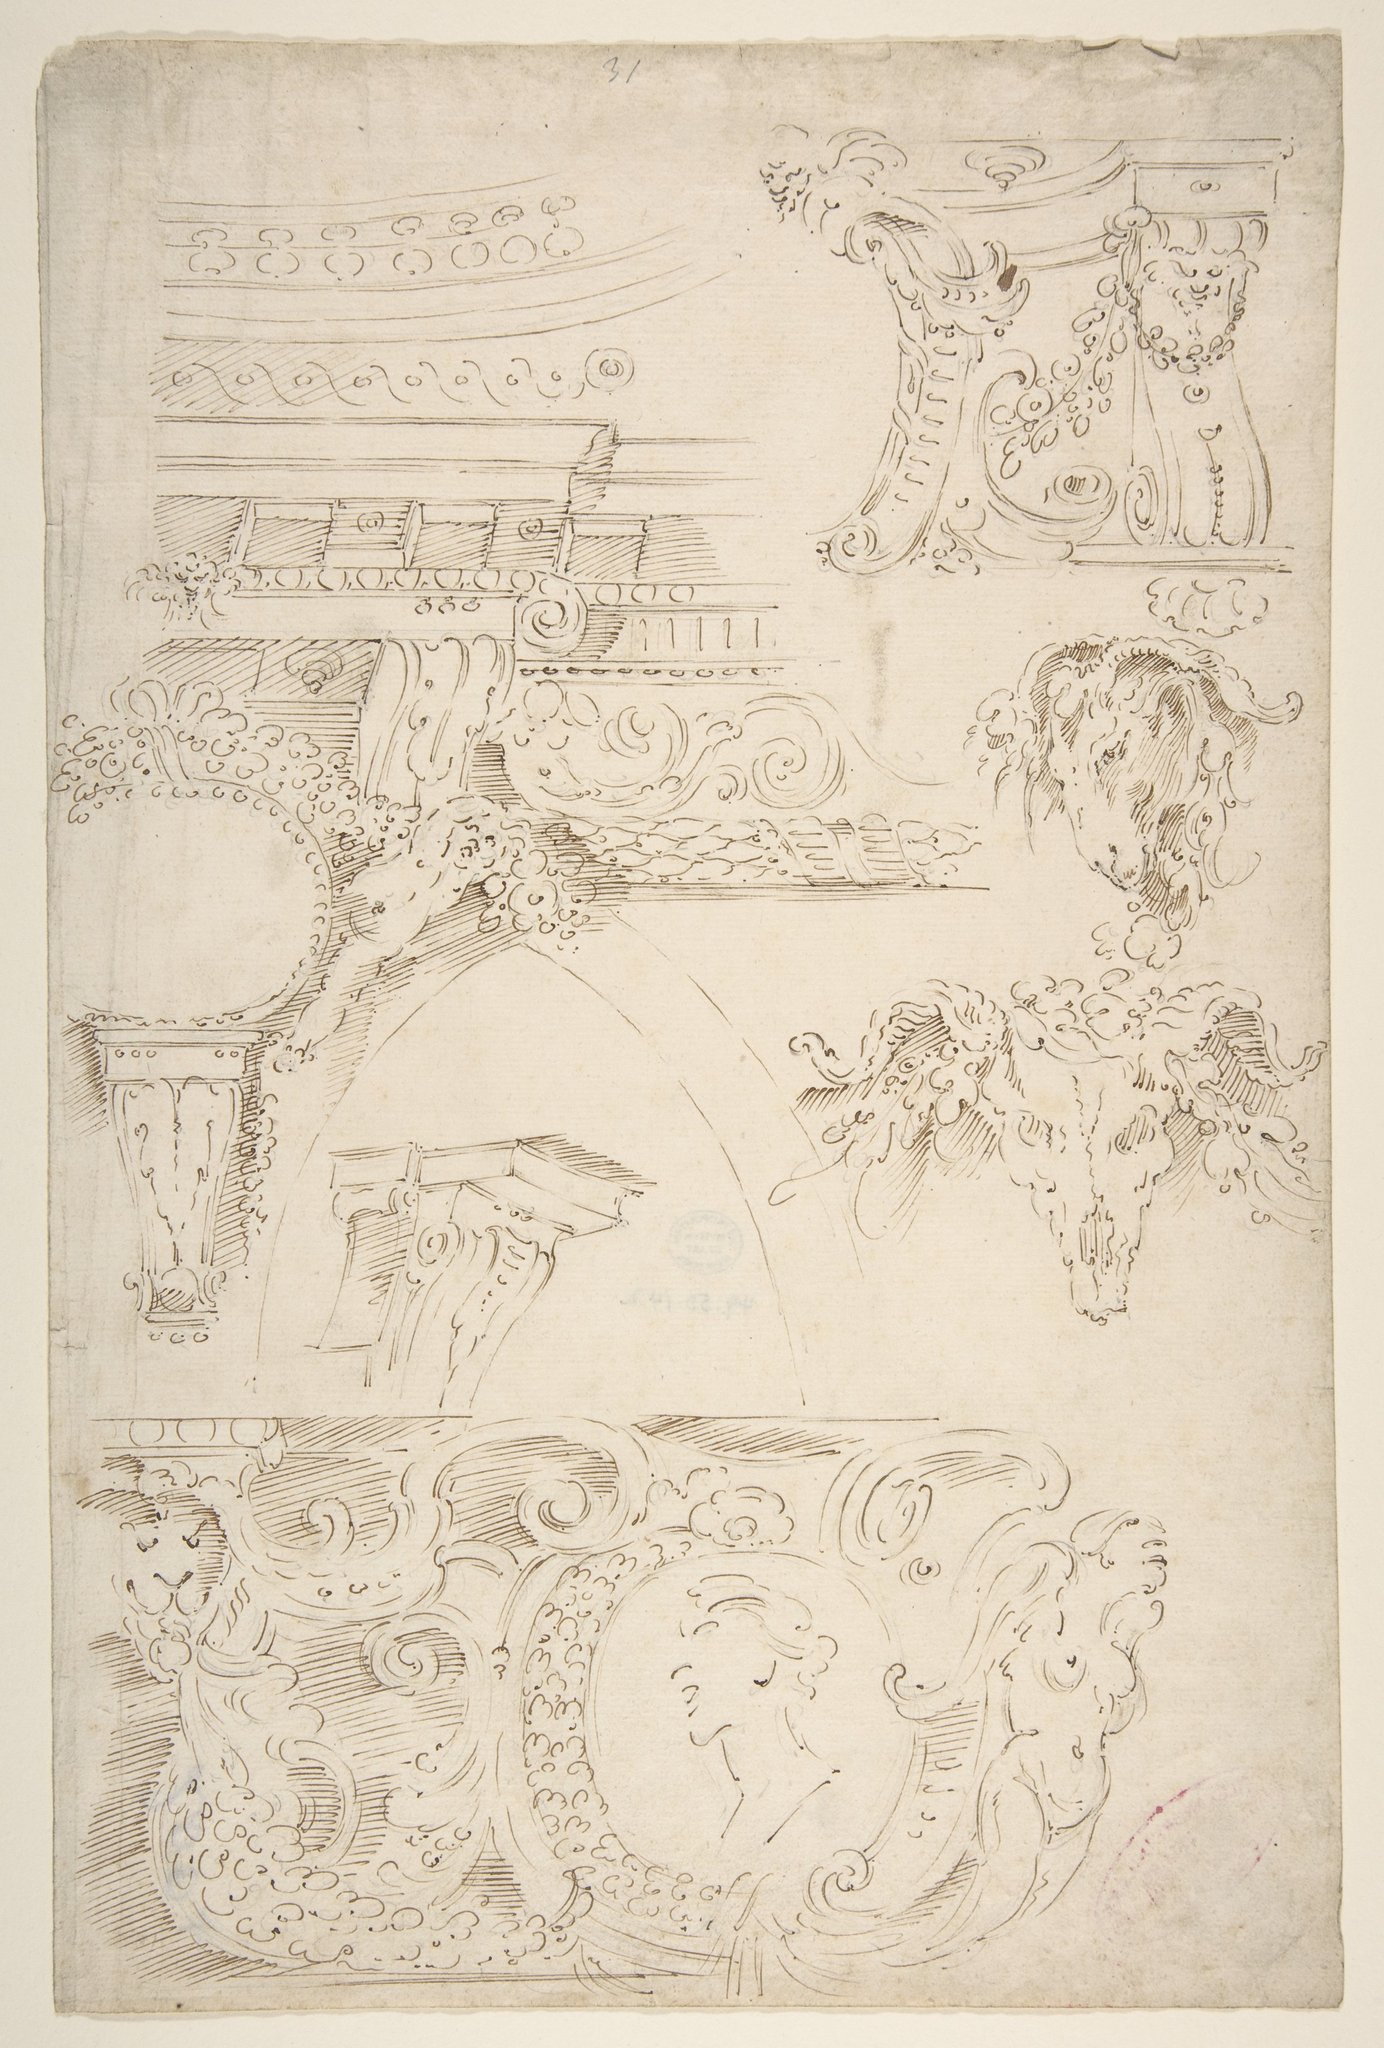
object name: drawing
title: Sketches of Sculptured Decoration. Entablatures and a Frieze with Human, Animal and Floral Ornaments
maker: agostino (stanzani) mitelli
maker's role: artist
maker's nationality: italian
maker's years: 1609-1660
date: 1634-1666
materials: graphite, ink, drawing material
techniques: pen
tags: ornament